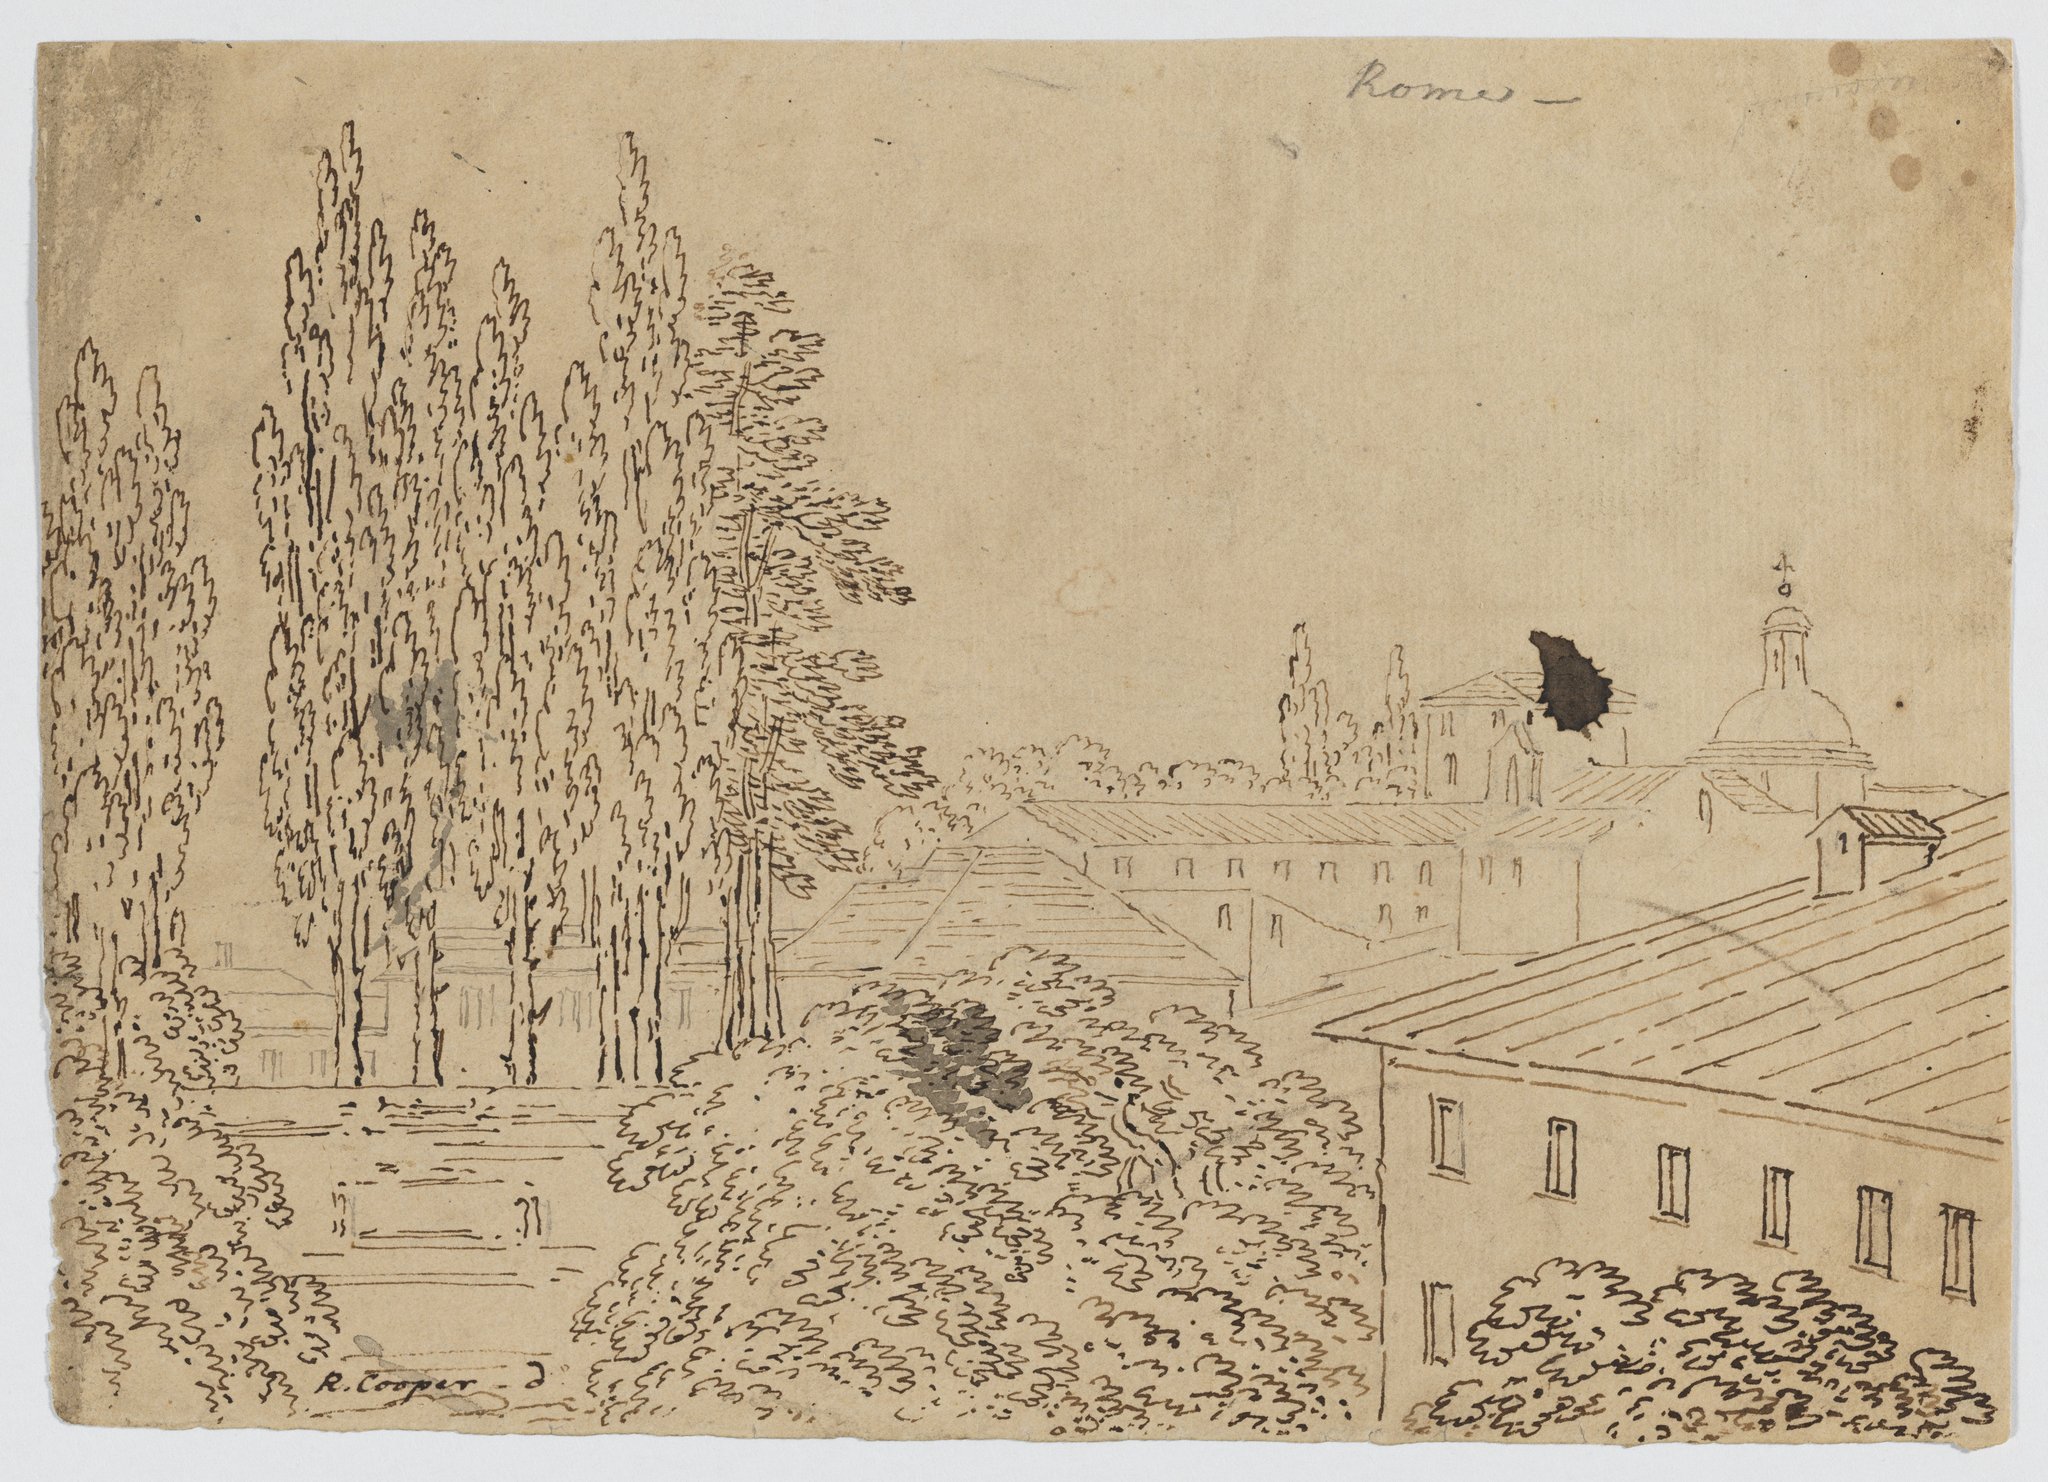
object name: drawing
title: Rome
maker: richard cooper ii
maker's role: artist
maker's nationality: british, scottish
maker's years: 1740-1822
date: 1774-1775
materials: graphite, ink, iron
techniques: pen, wash